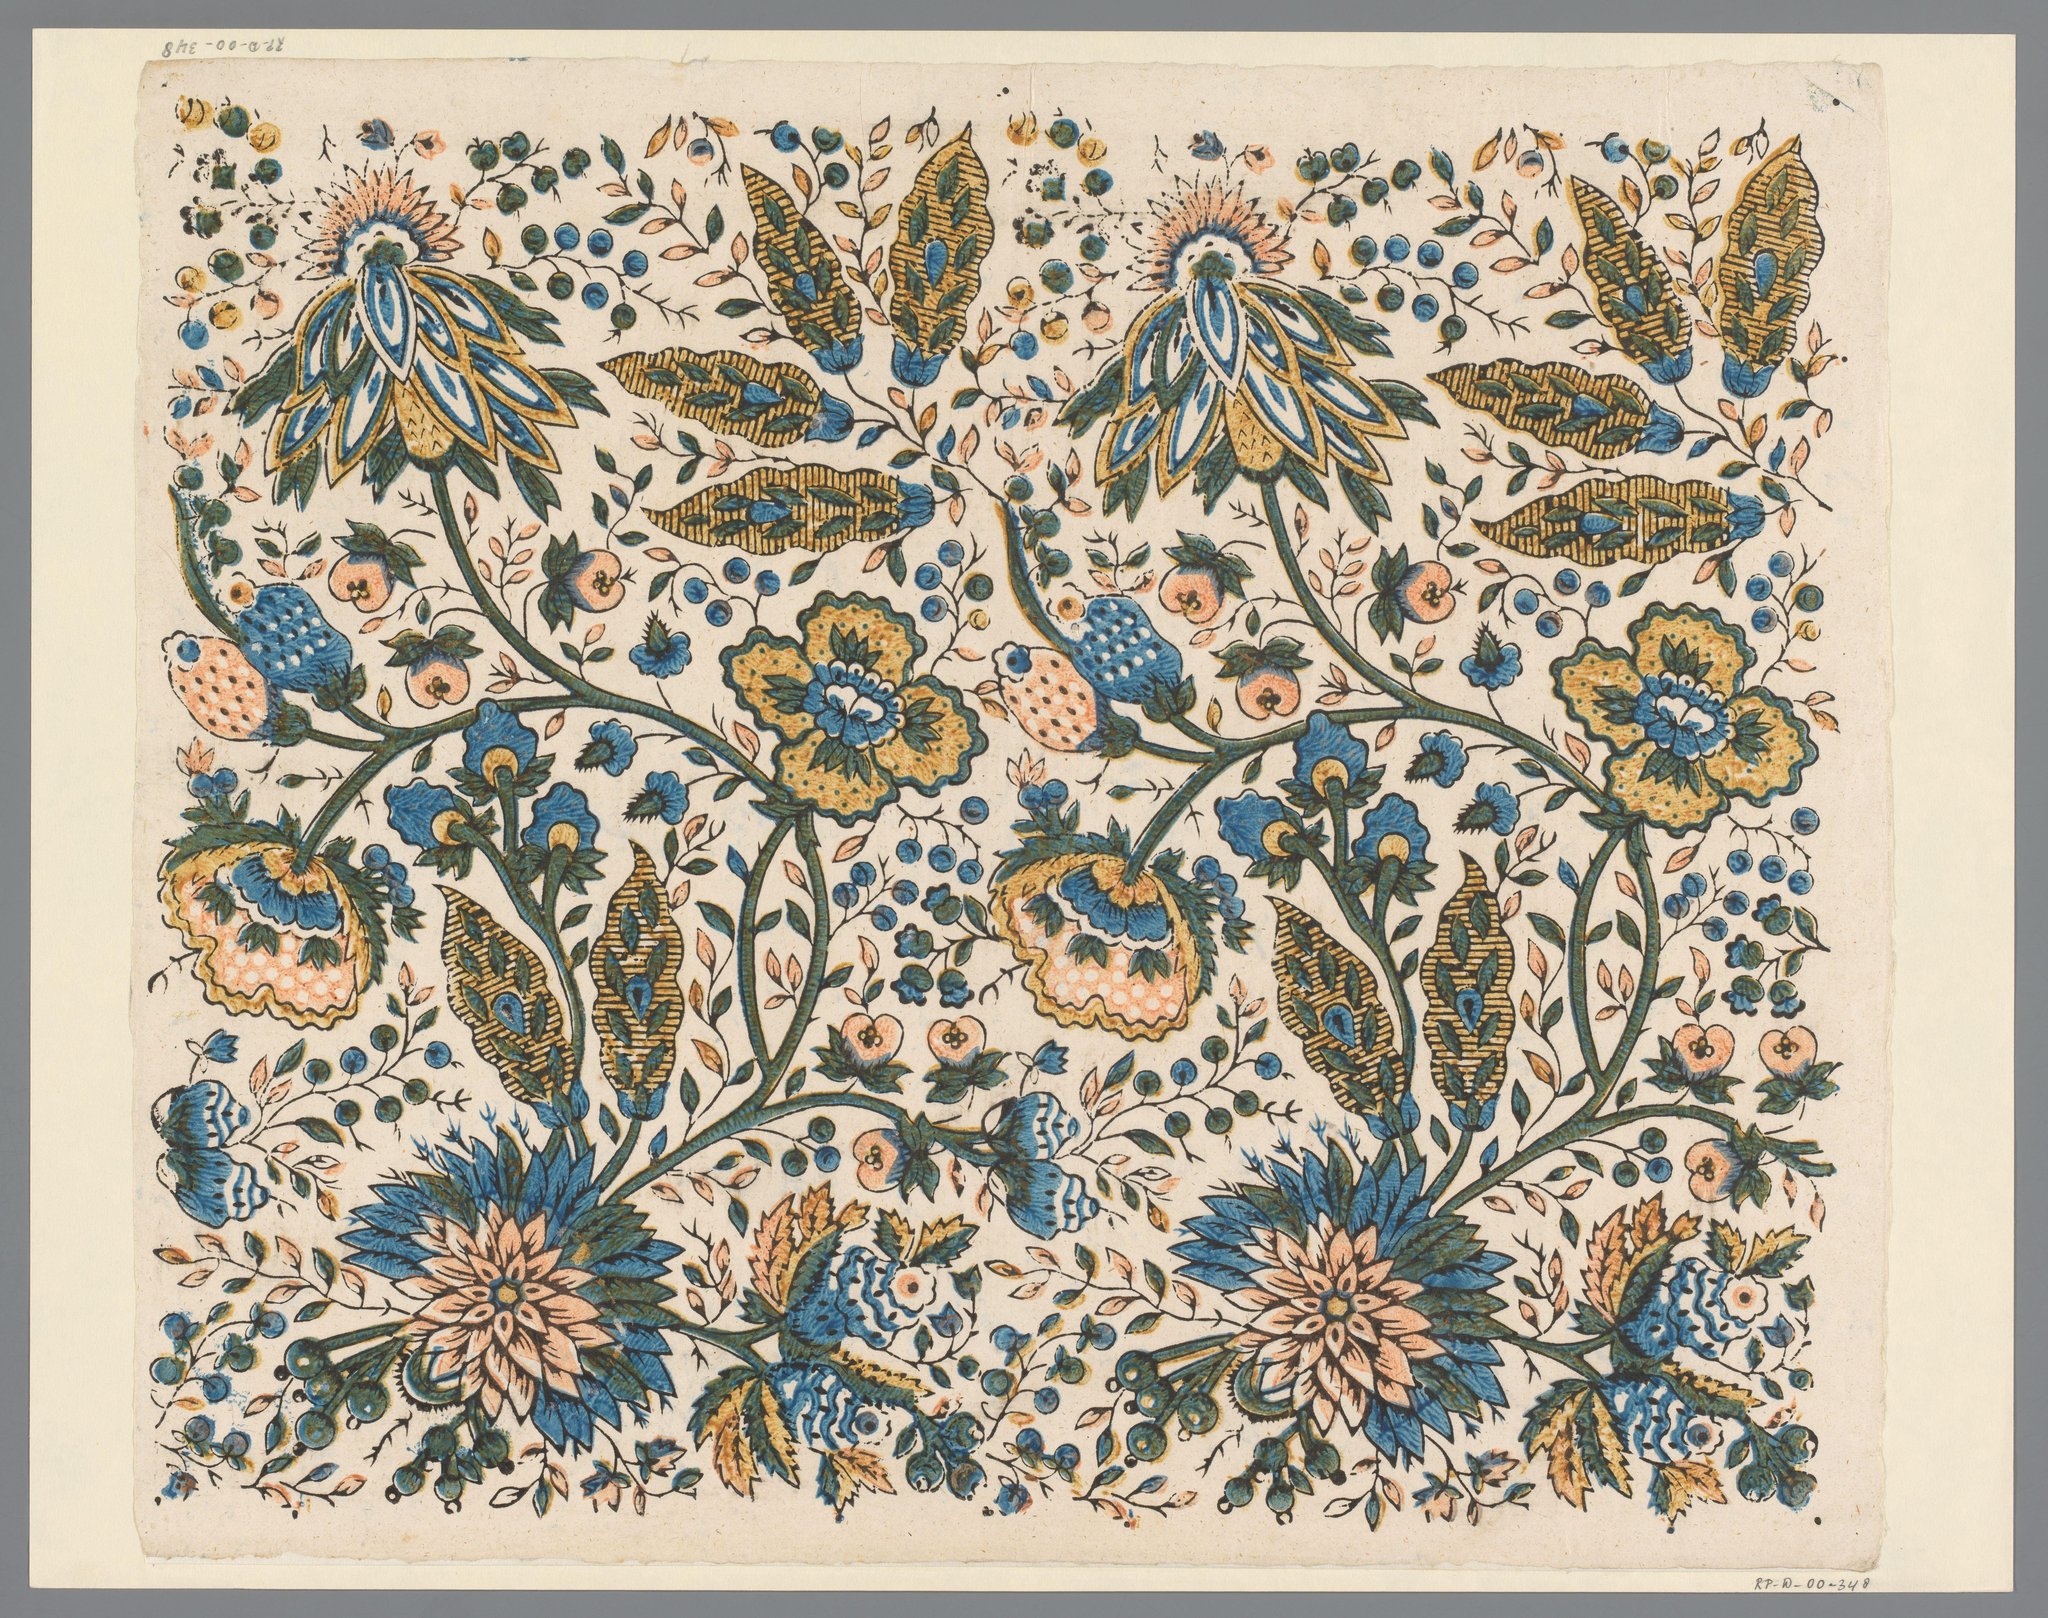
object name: printed paper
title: Blad met fantasie 'Perzische' bloemen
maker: Anonymous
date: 1800-1850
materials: paper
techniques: printing block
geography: netherlands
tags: ornament derived from plant forms